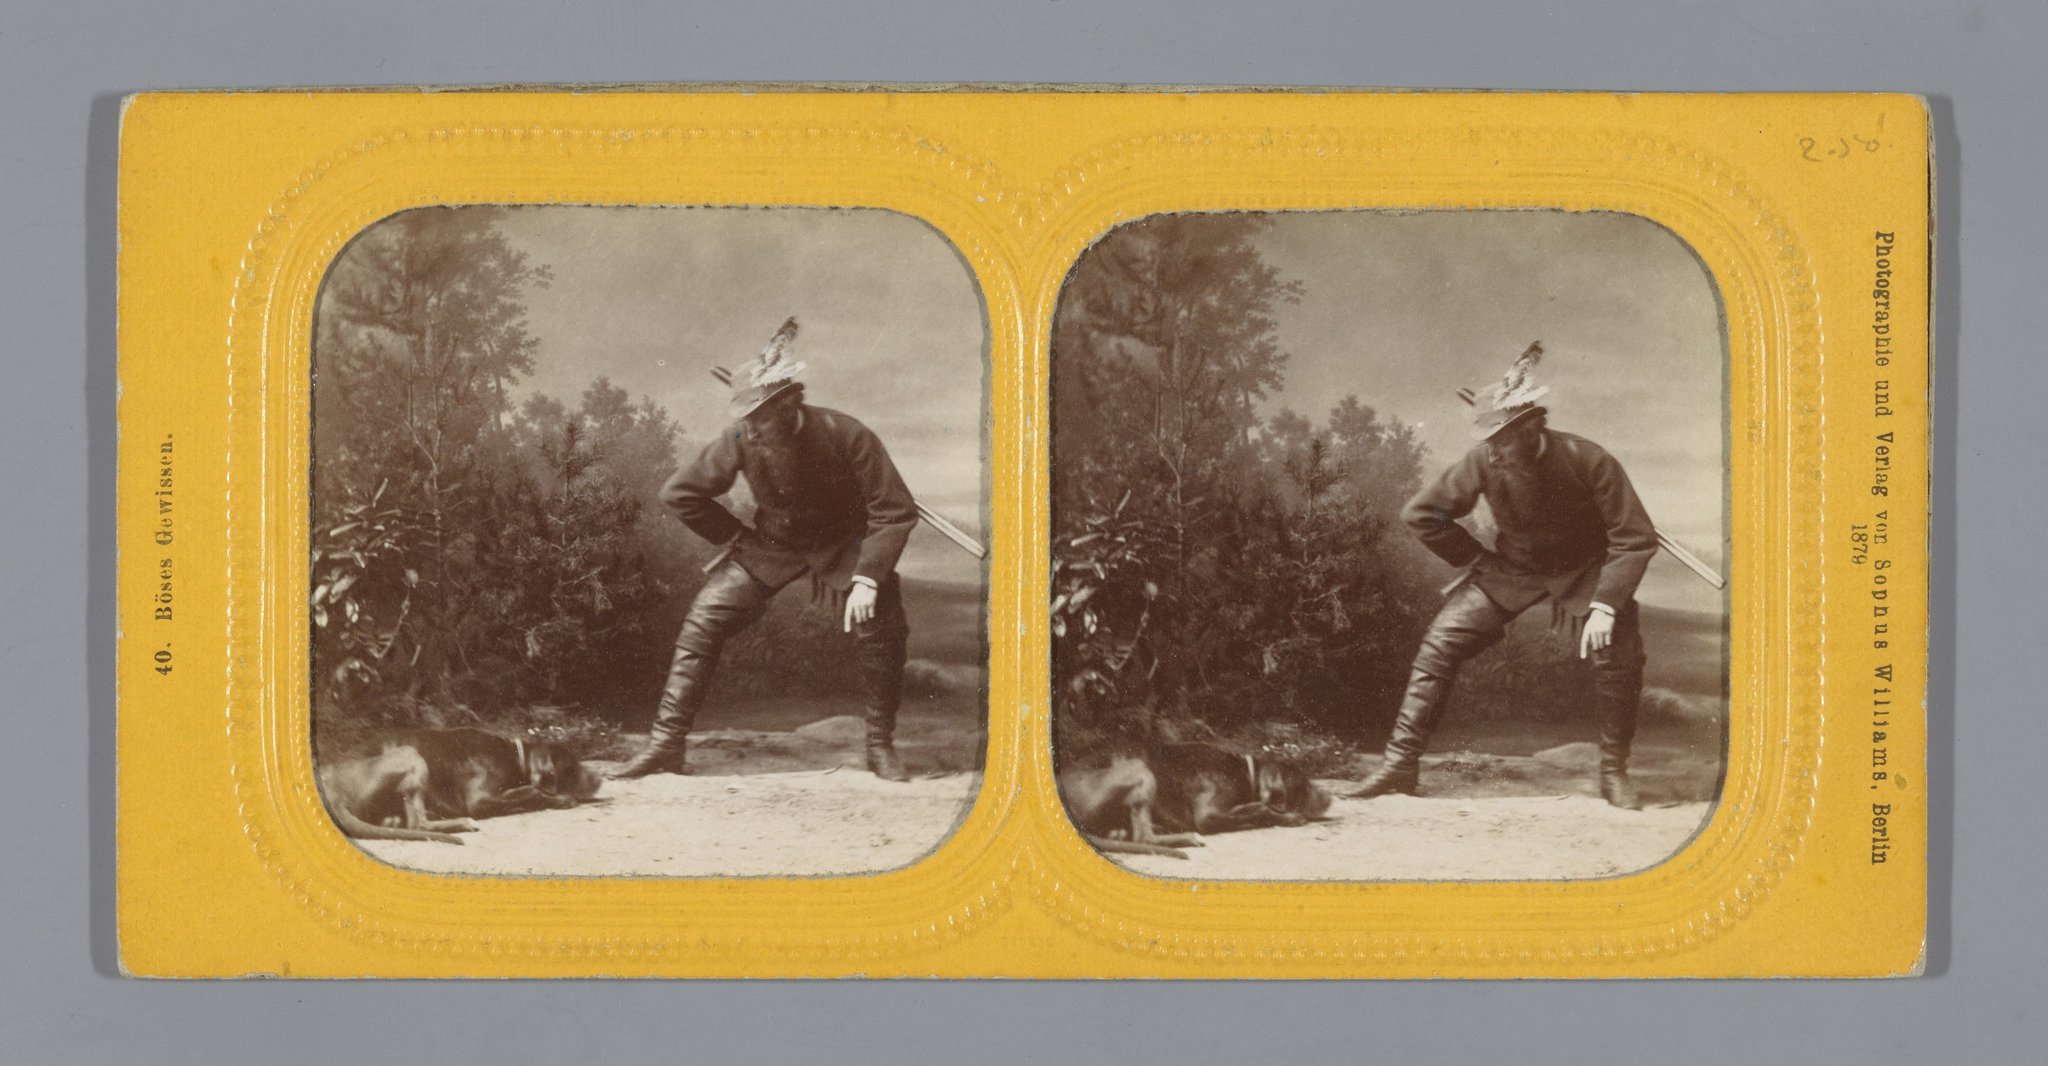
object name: tissue stereograph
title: Böses gewissen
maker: sophus williams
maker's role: publisher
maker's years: 1835-1900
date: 1879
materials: cardboard, paper, photographic support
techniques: albumen print, hand coloring, perforating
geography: berlin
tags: adult man, dog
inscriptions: number: ‘40.’, inscription: ‘2.50’